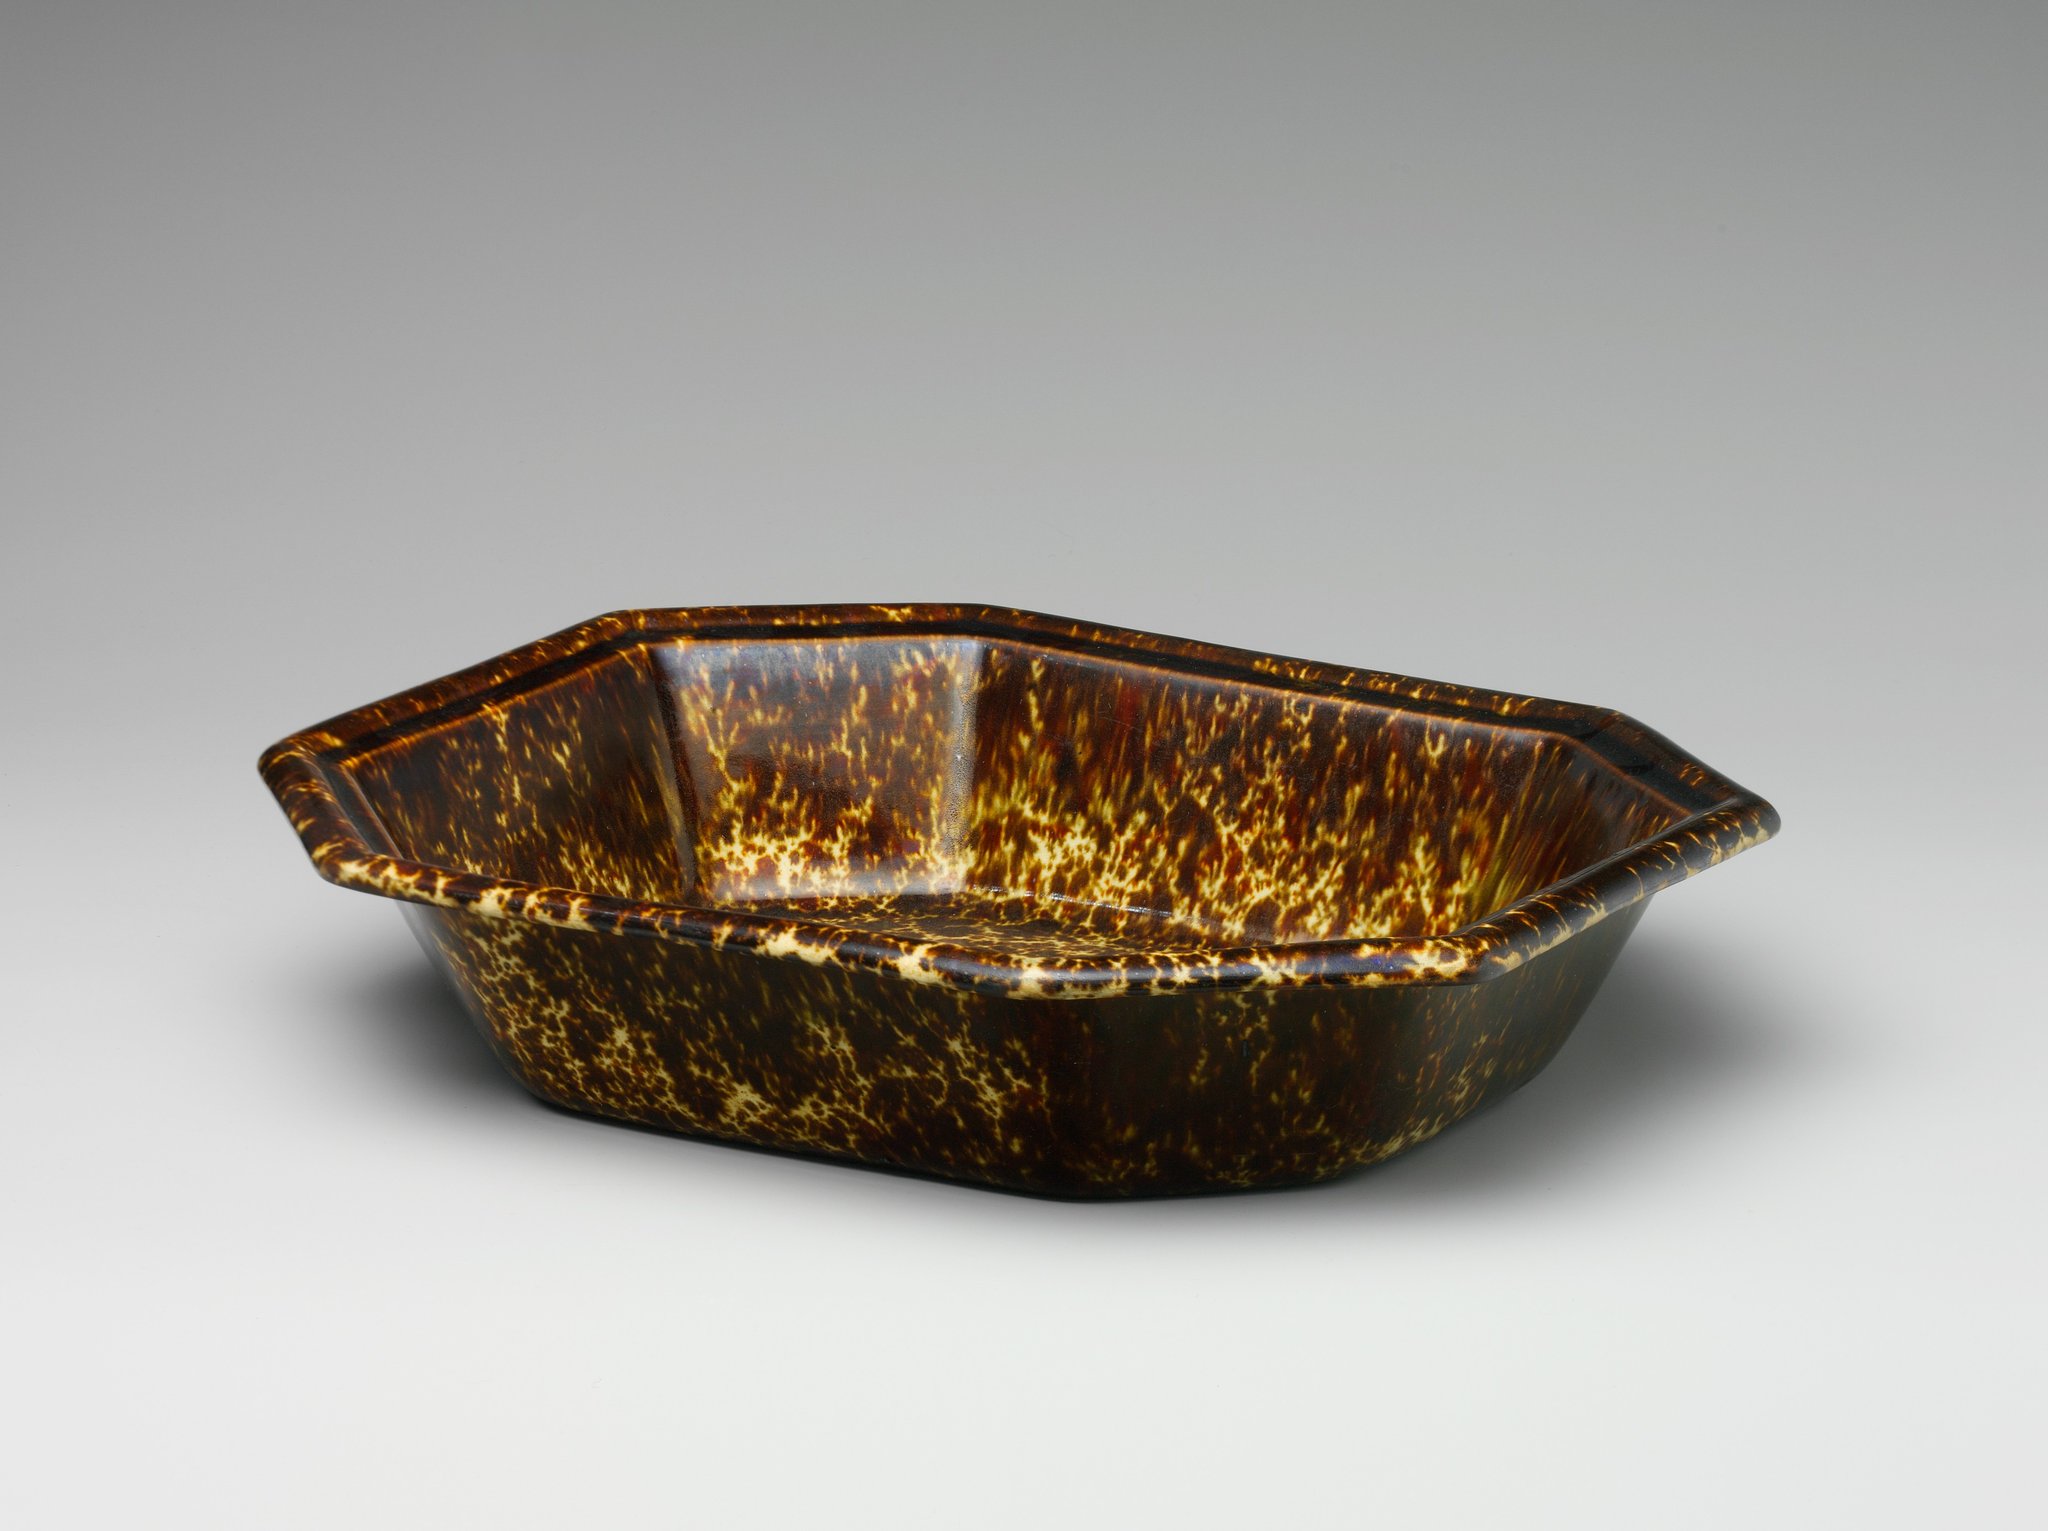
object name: dish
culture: american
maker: lyman, fenton & co.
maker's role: maker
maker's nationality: american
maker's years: 1849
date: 1849-1858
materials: earthenware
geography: united states